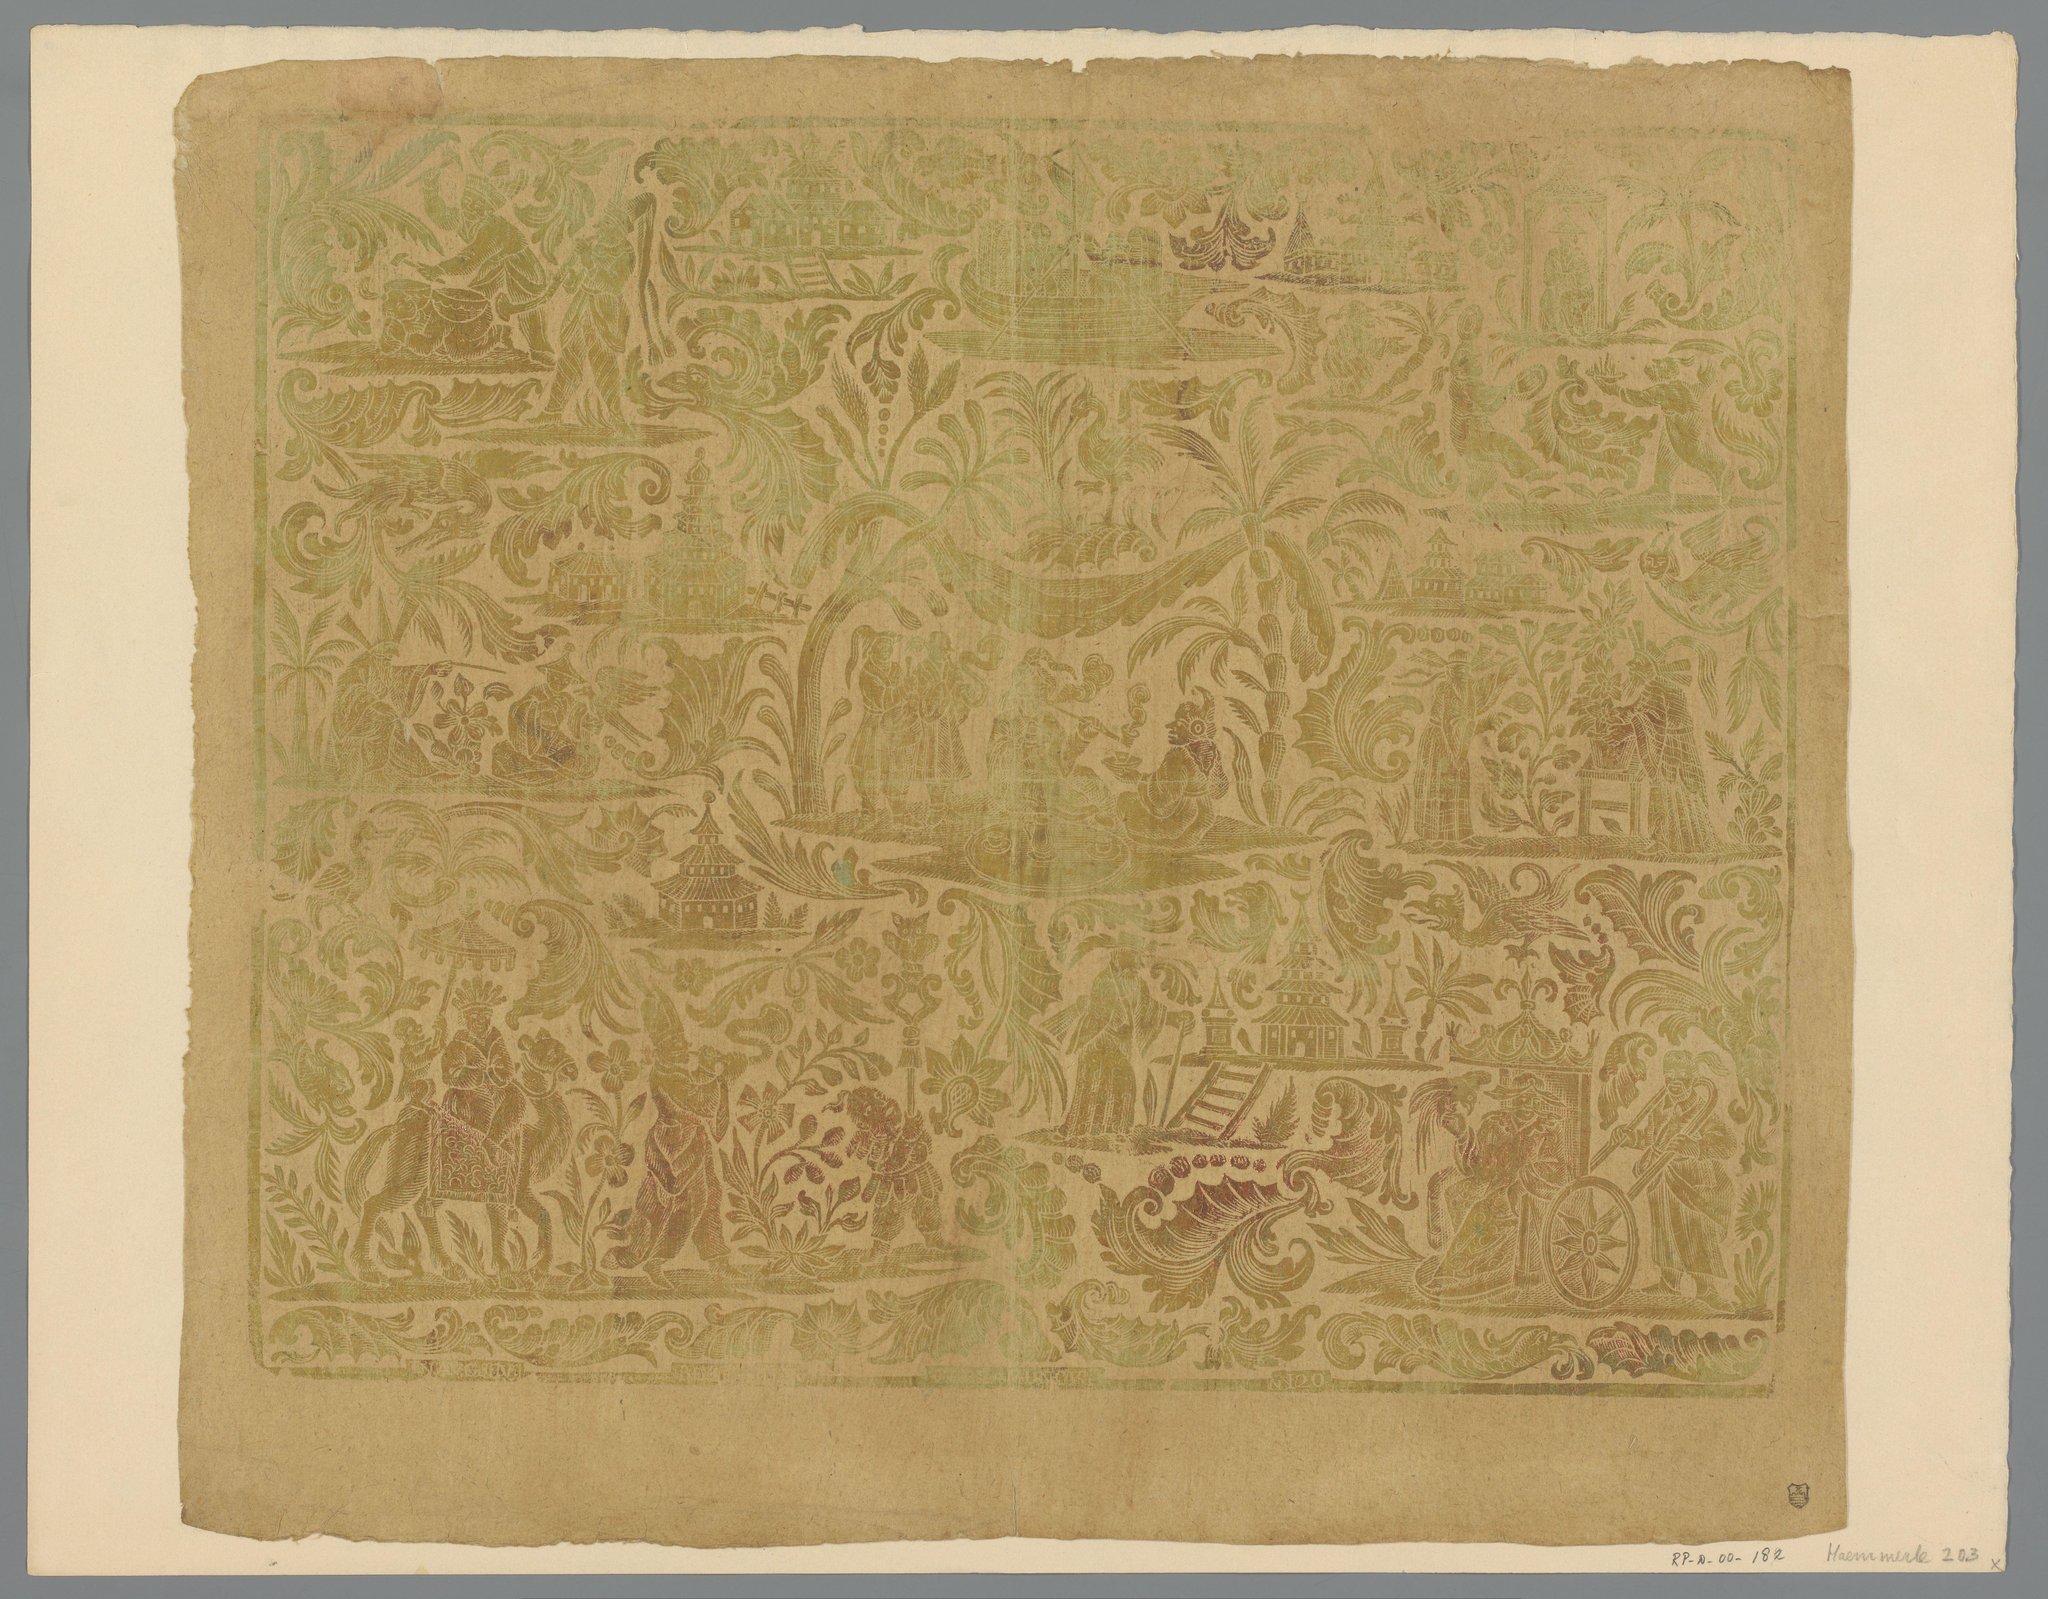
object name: brocade paper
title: Decorative paper with Chinoiserie motifs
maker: johann carl munck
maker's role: ontwerper sierpapier, papiermaker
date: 1750-1794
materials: gold leaf, paint, paper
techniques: relief print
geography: augsburg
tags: chinese, monkeys, apes, foliage, tendrils, branches ~ ornament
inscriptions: collector's mark: Lugt 2760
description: Blad met ranken en chinoiserieën, linksboven twee mannen waarvan een liggend en een staande trommelend, rechtsboven dansende figuren voor een altaar, linksonder man op kameel en aap en zonnescherm, rechtsonder een man in een riksja. Rechtsonder genummerd: 120.